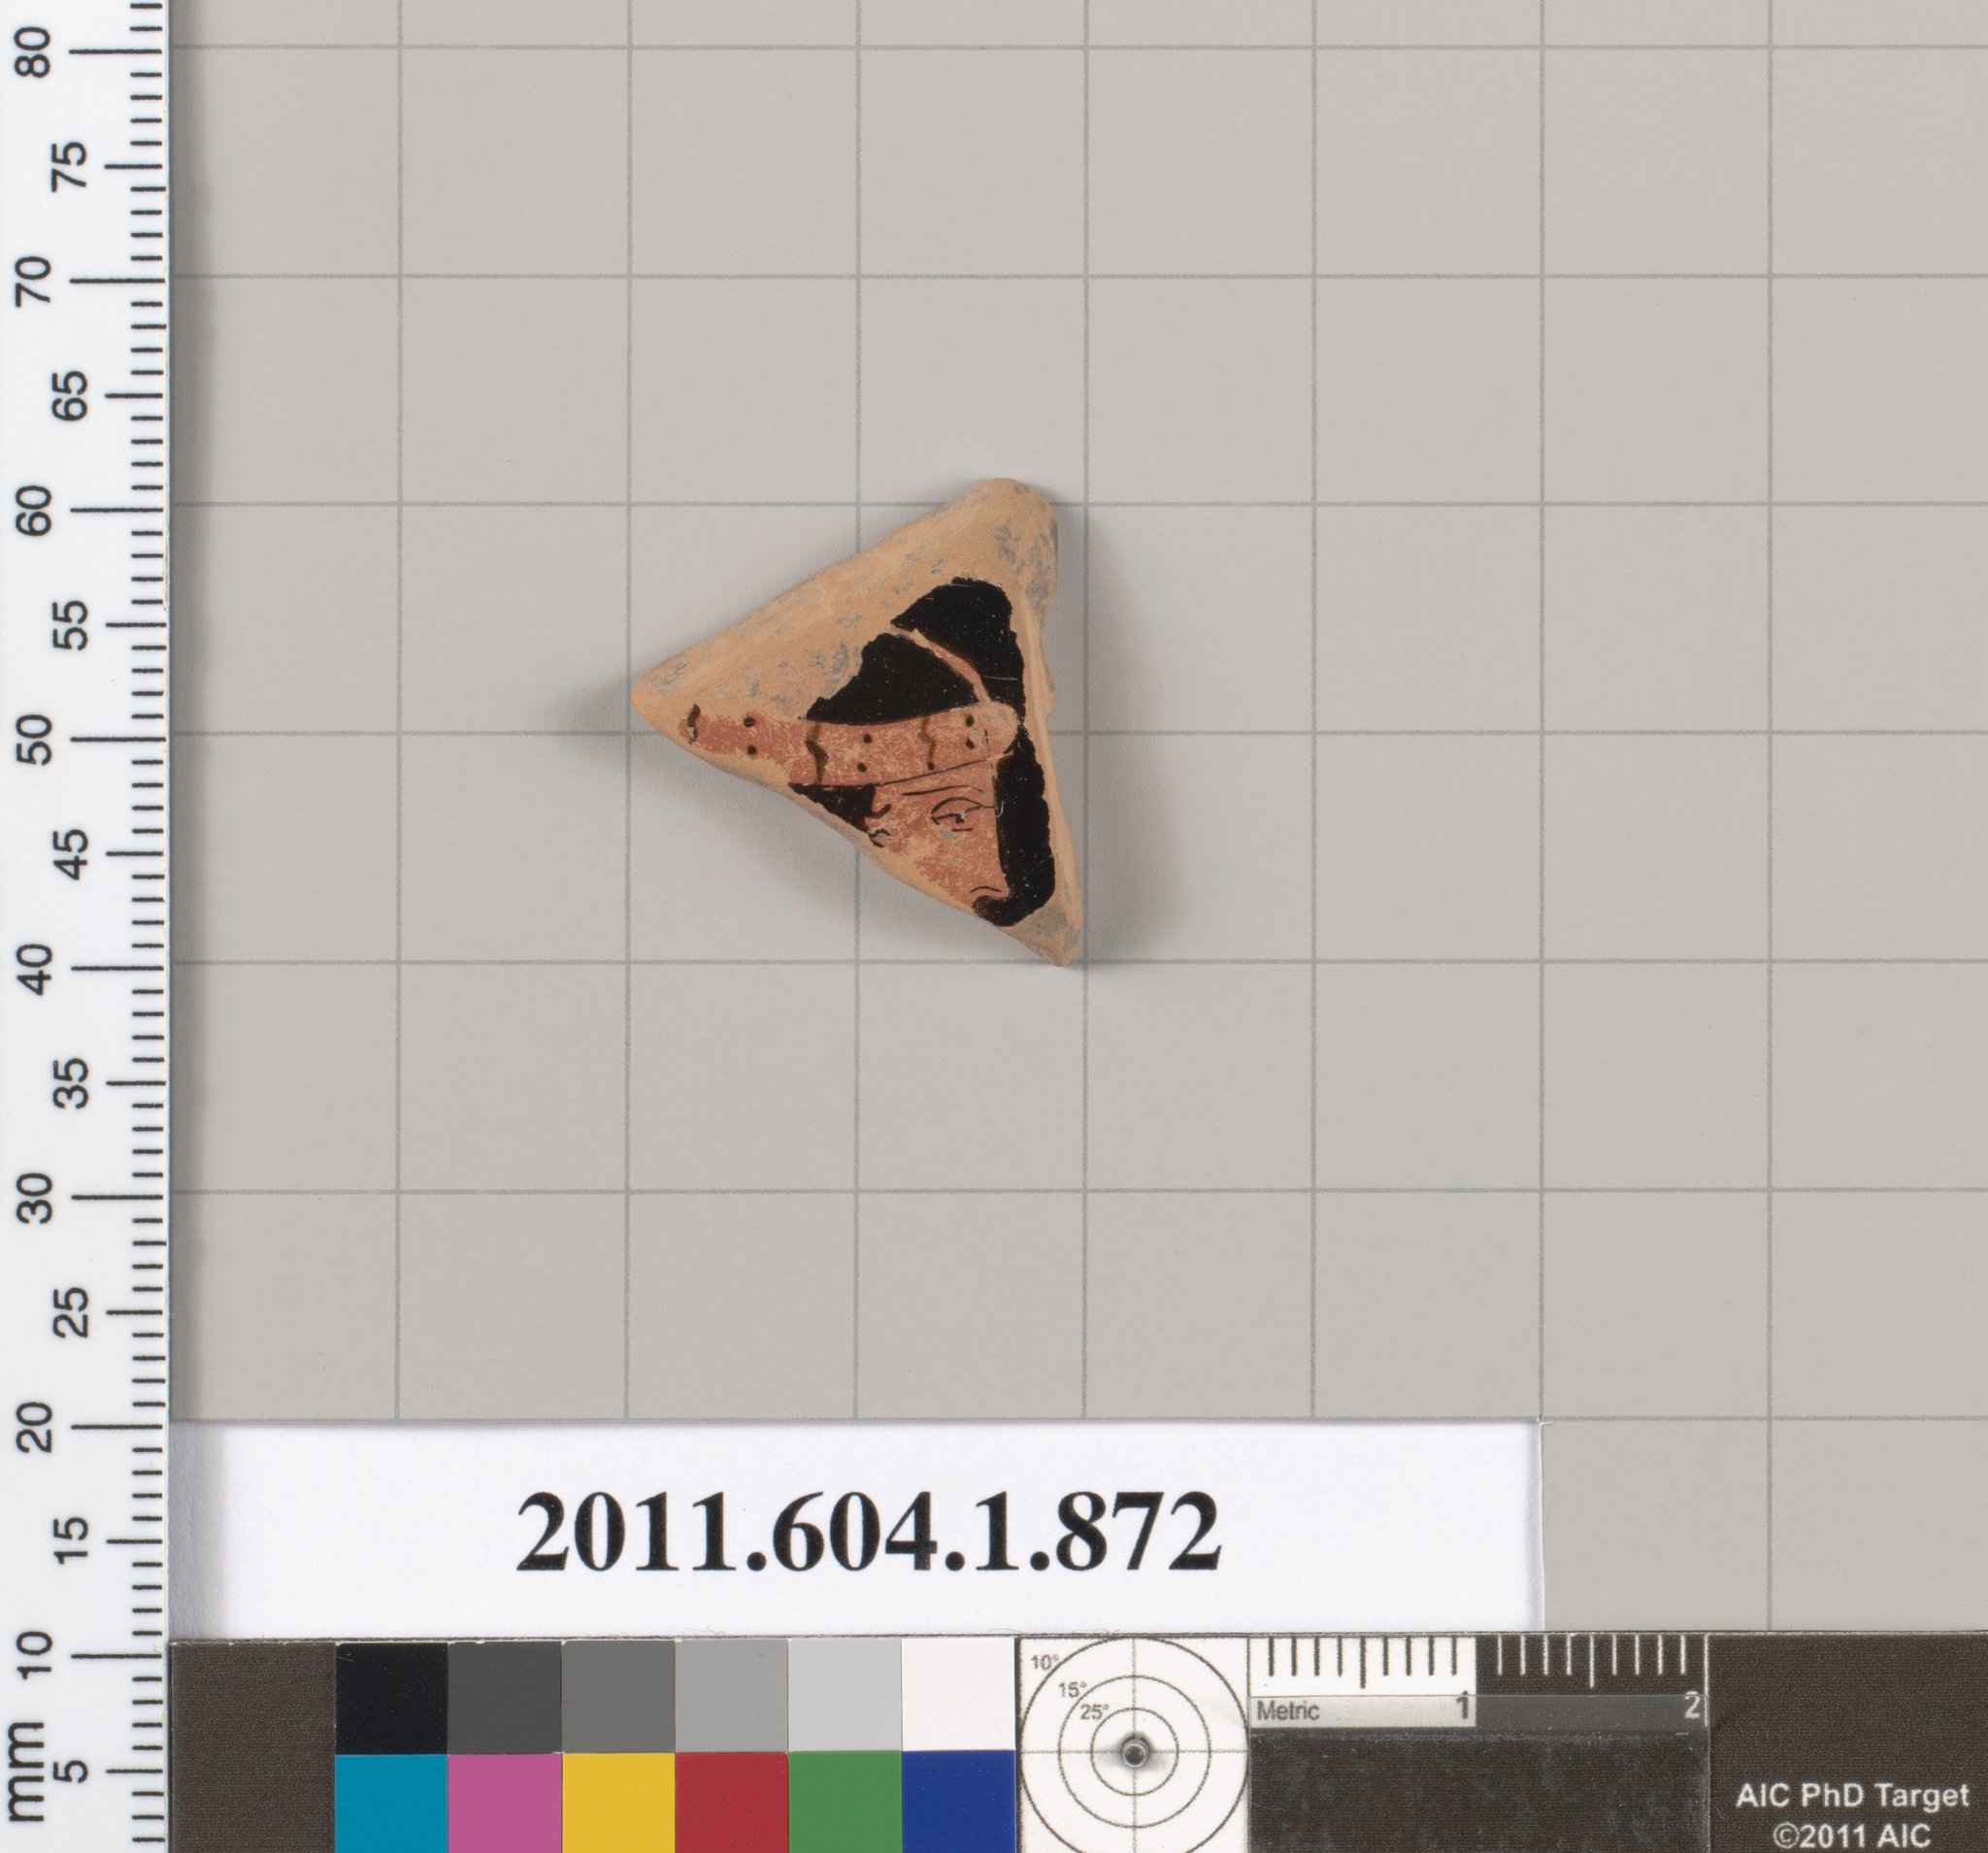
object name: kylix fragment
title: Terracotta fragment of a kylix (drinking cup)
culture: greek, attic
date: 475-451 BCE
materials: terracotta